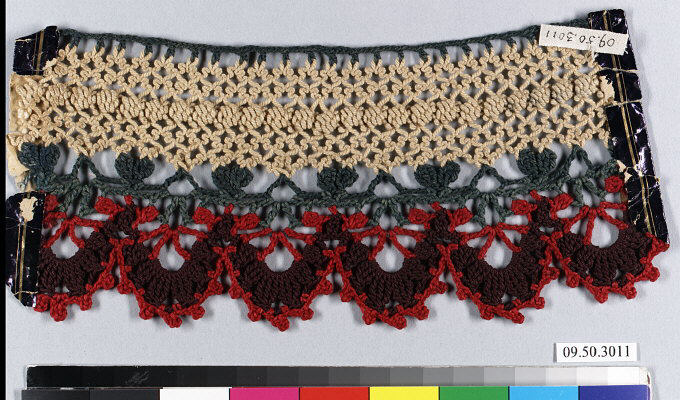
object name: piece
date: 1801-1900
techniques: crochet